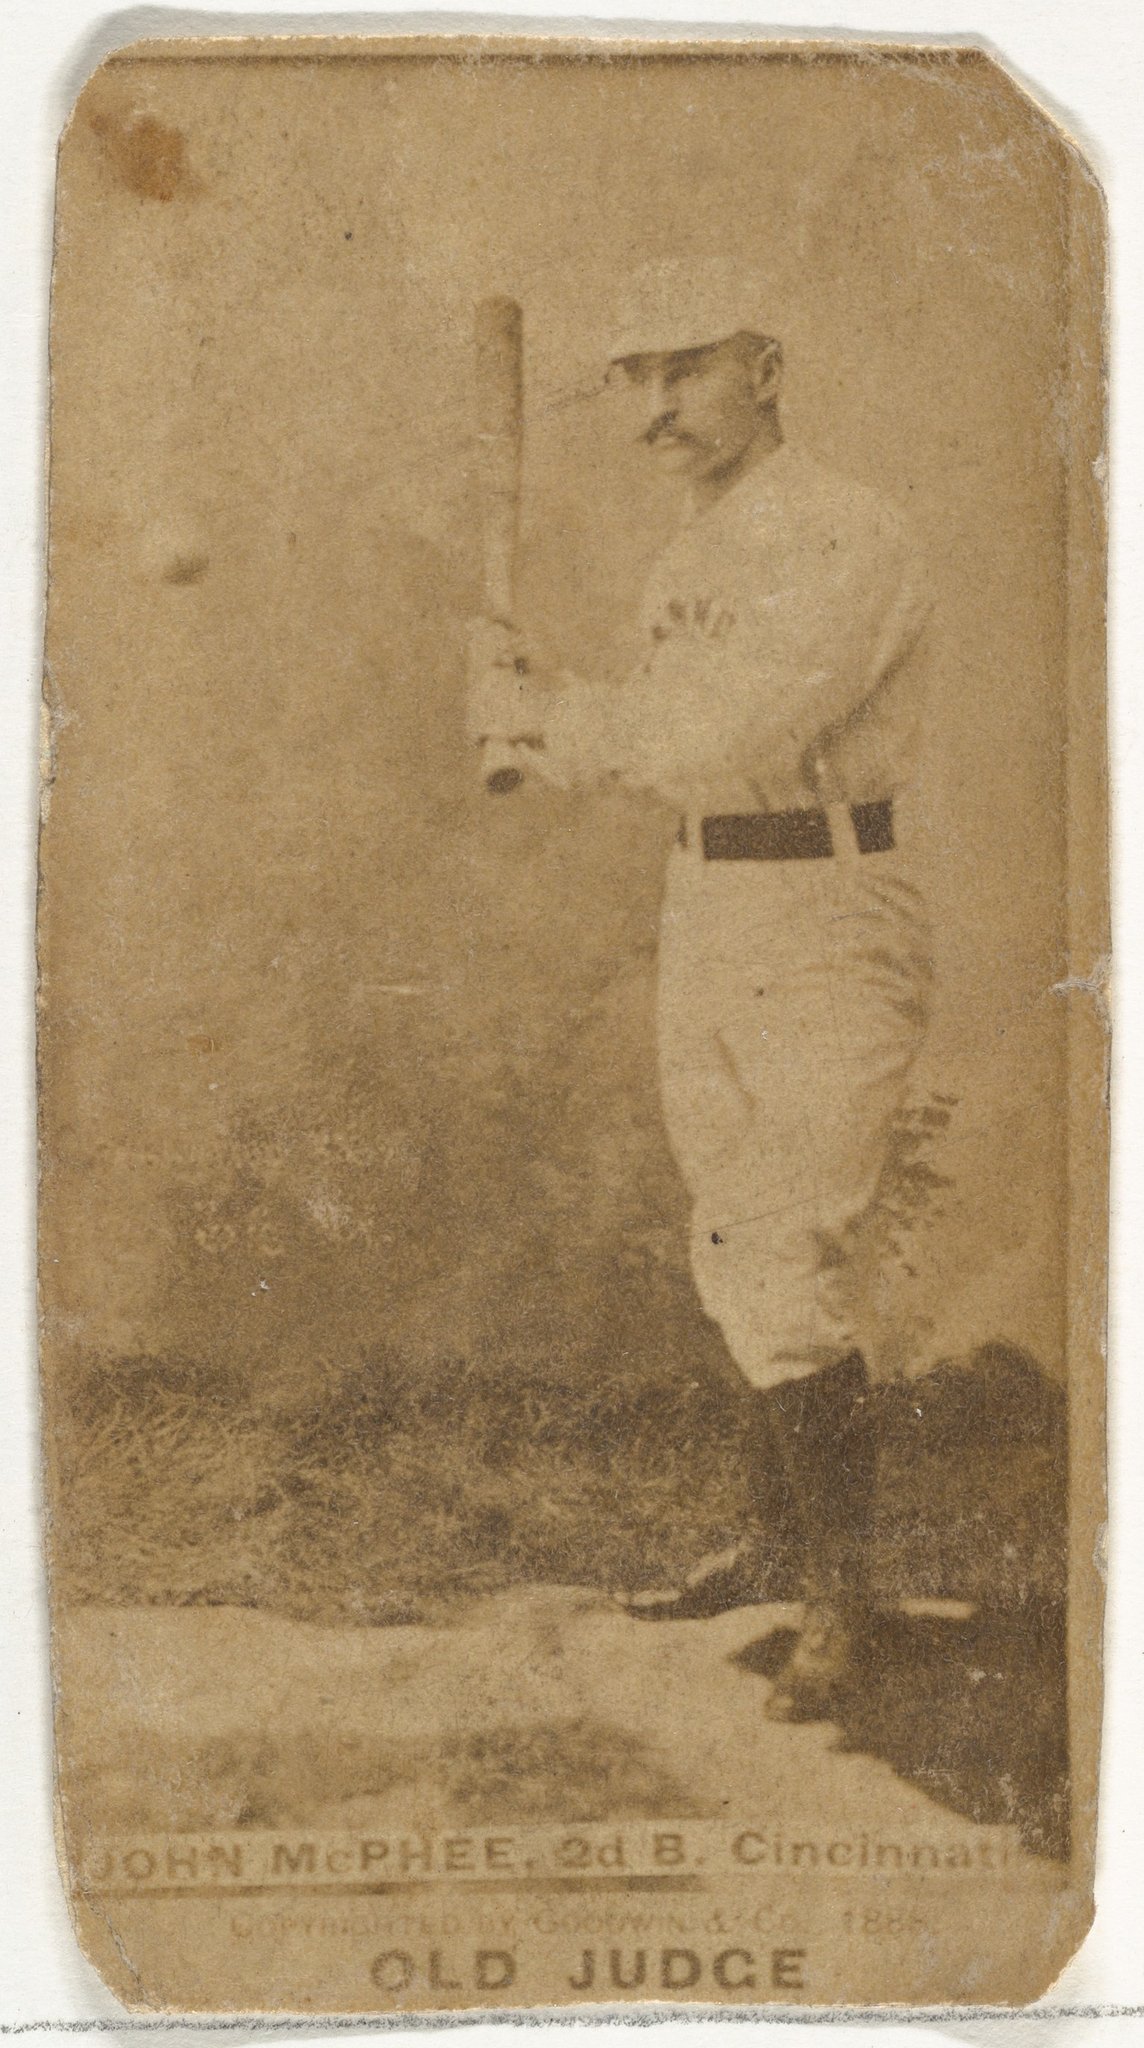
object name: baseball card, photograph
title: John Alexander "Bid" McPhee, 2nd Base, Cincinnati, from the Old Judge series (N172) for Old Judge Cigarettes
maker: goodwin & company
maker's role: publisher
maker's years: 1850-1950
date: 1888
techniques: albumen silver print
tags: men,portraits,baseball,athletes